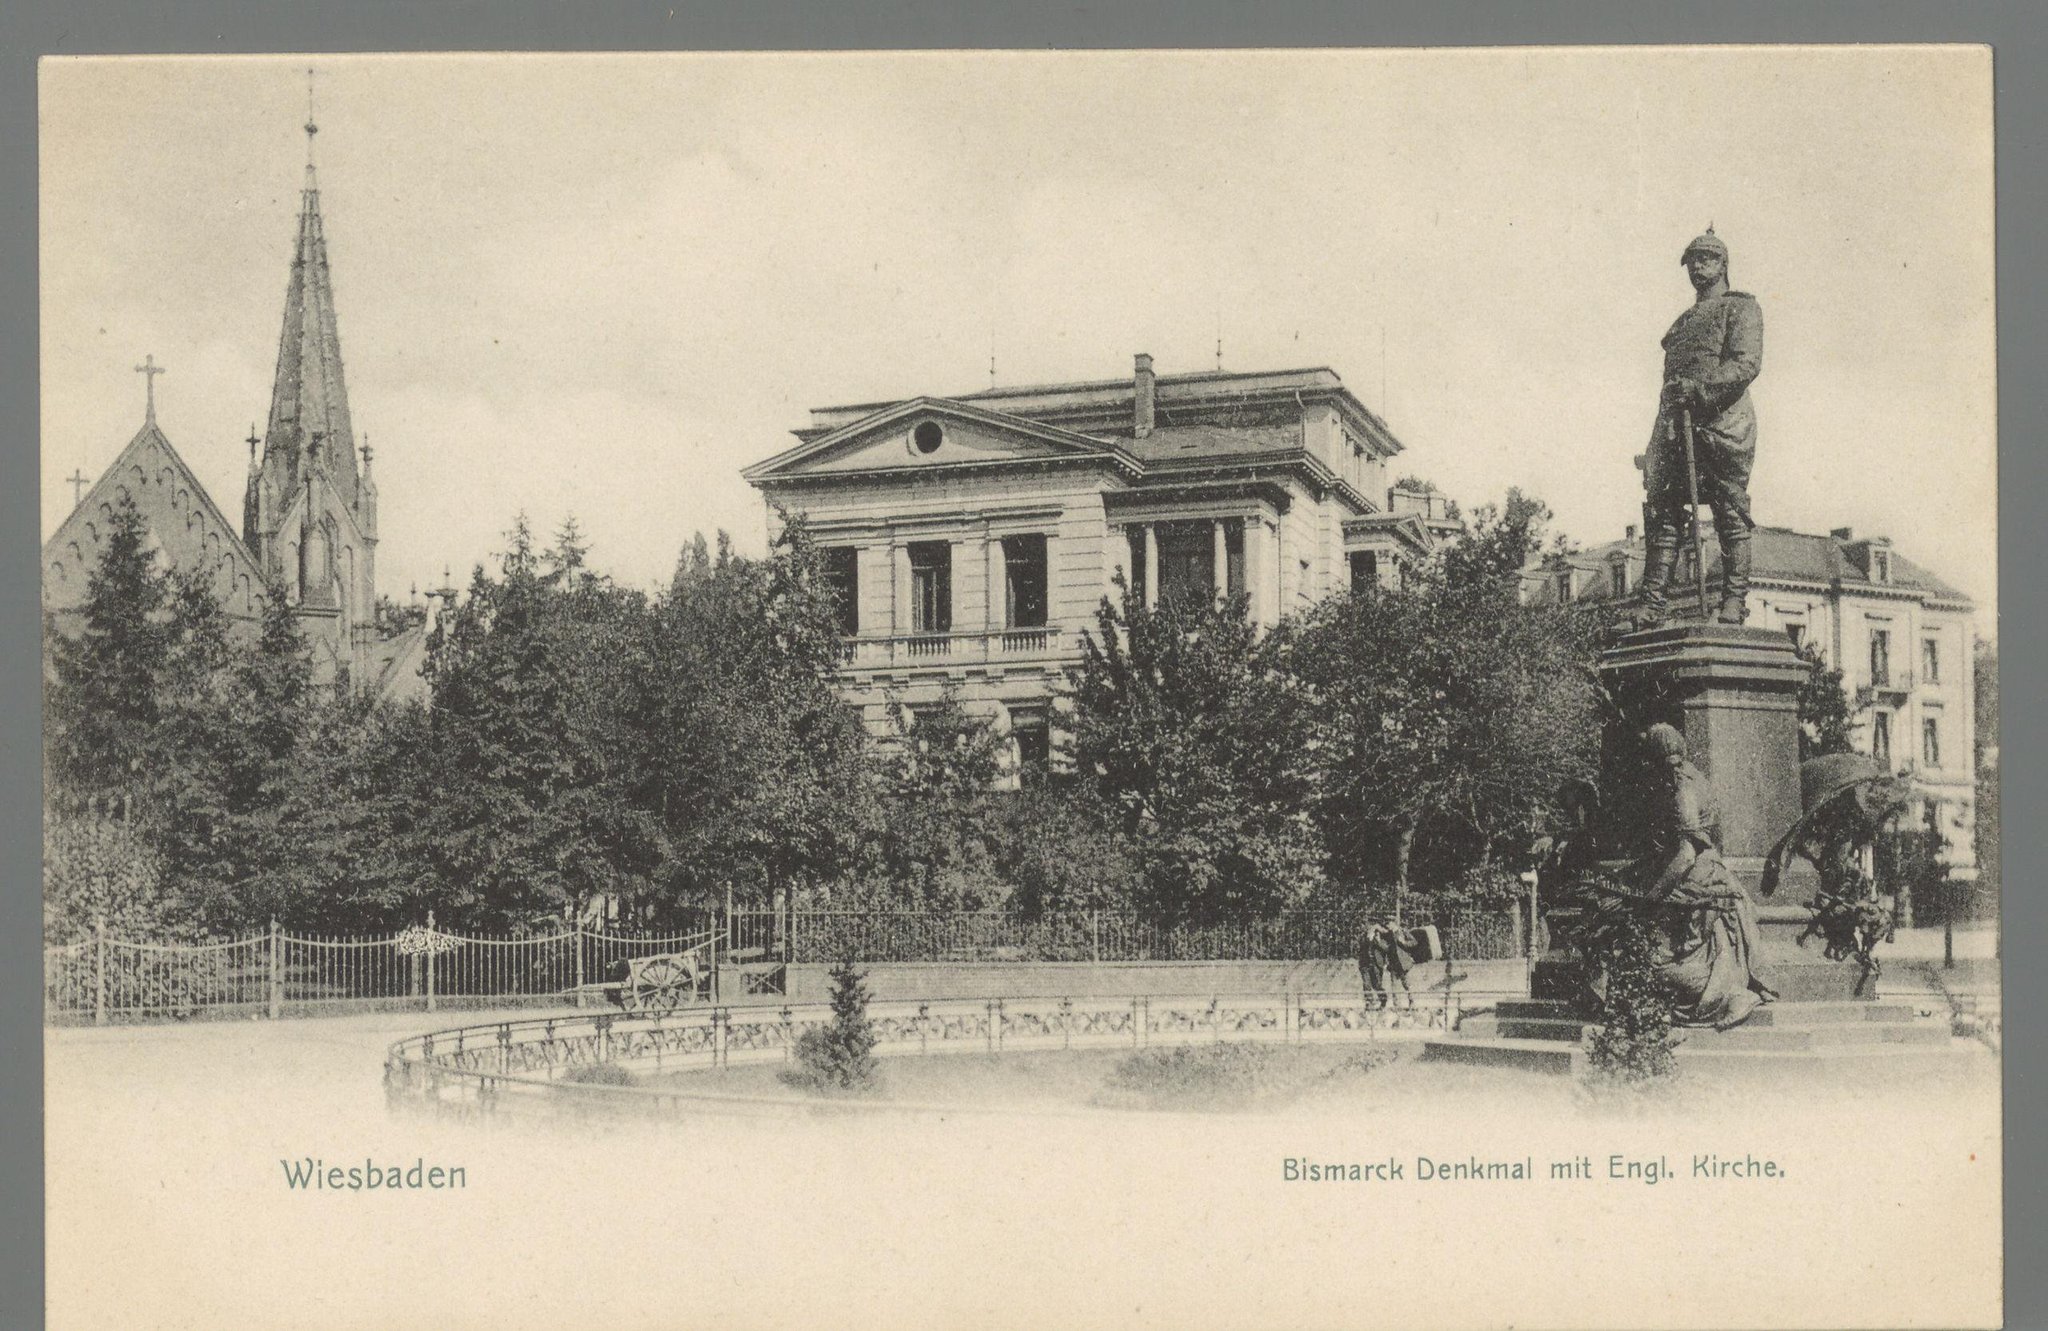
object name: photomechanical print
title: Wiesbaden. Bismarck Denkmal mit Engl. Kirche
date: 1905-1930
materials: cardboard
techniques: photograph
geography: wiesbaden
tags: church (exterior), monument, statue